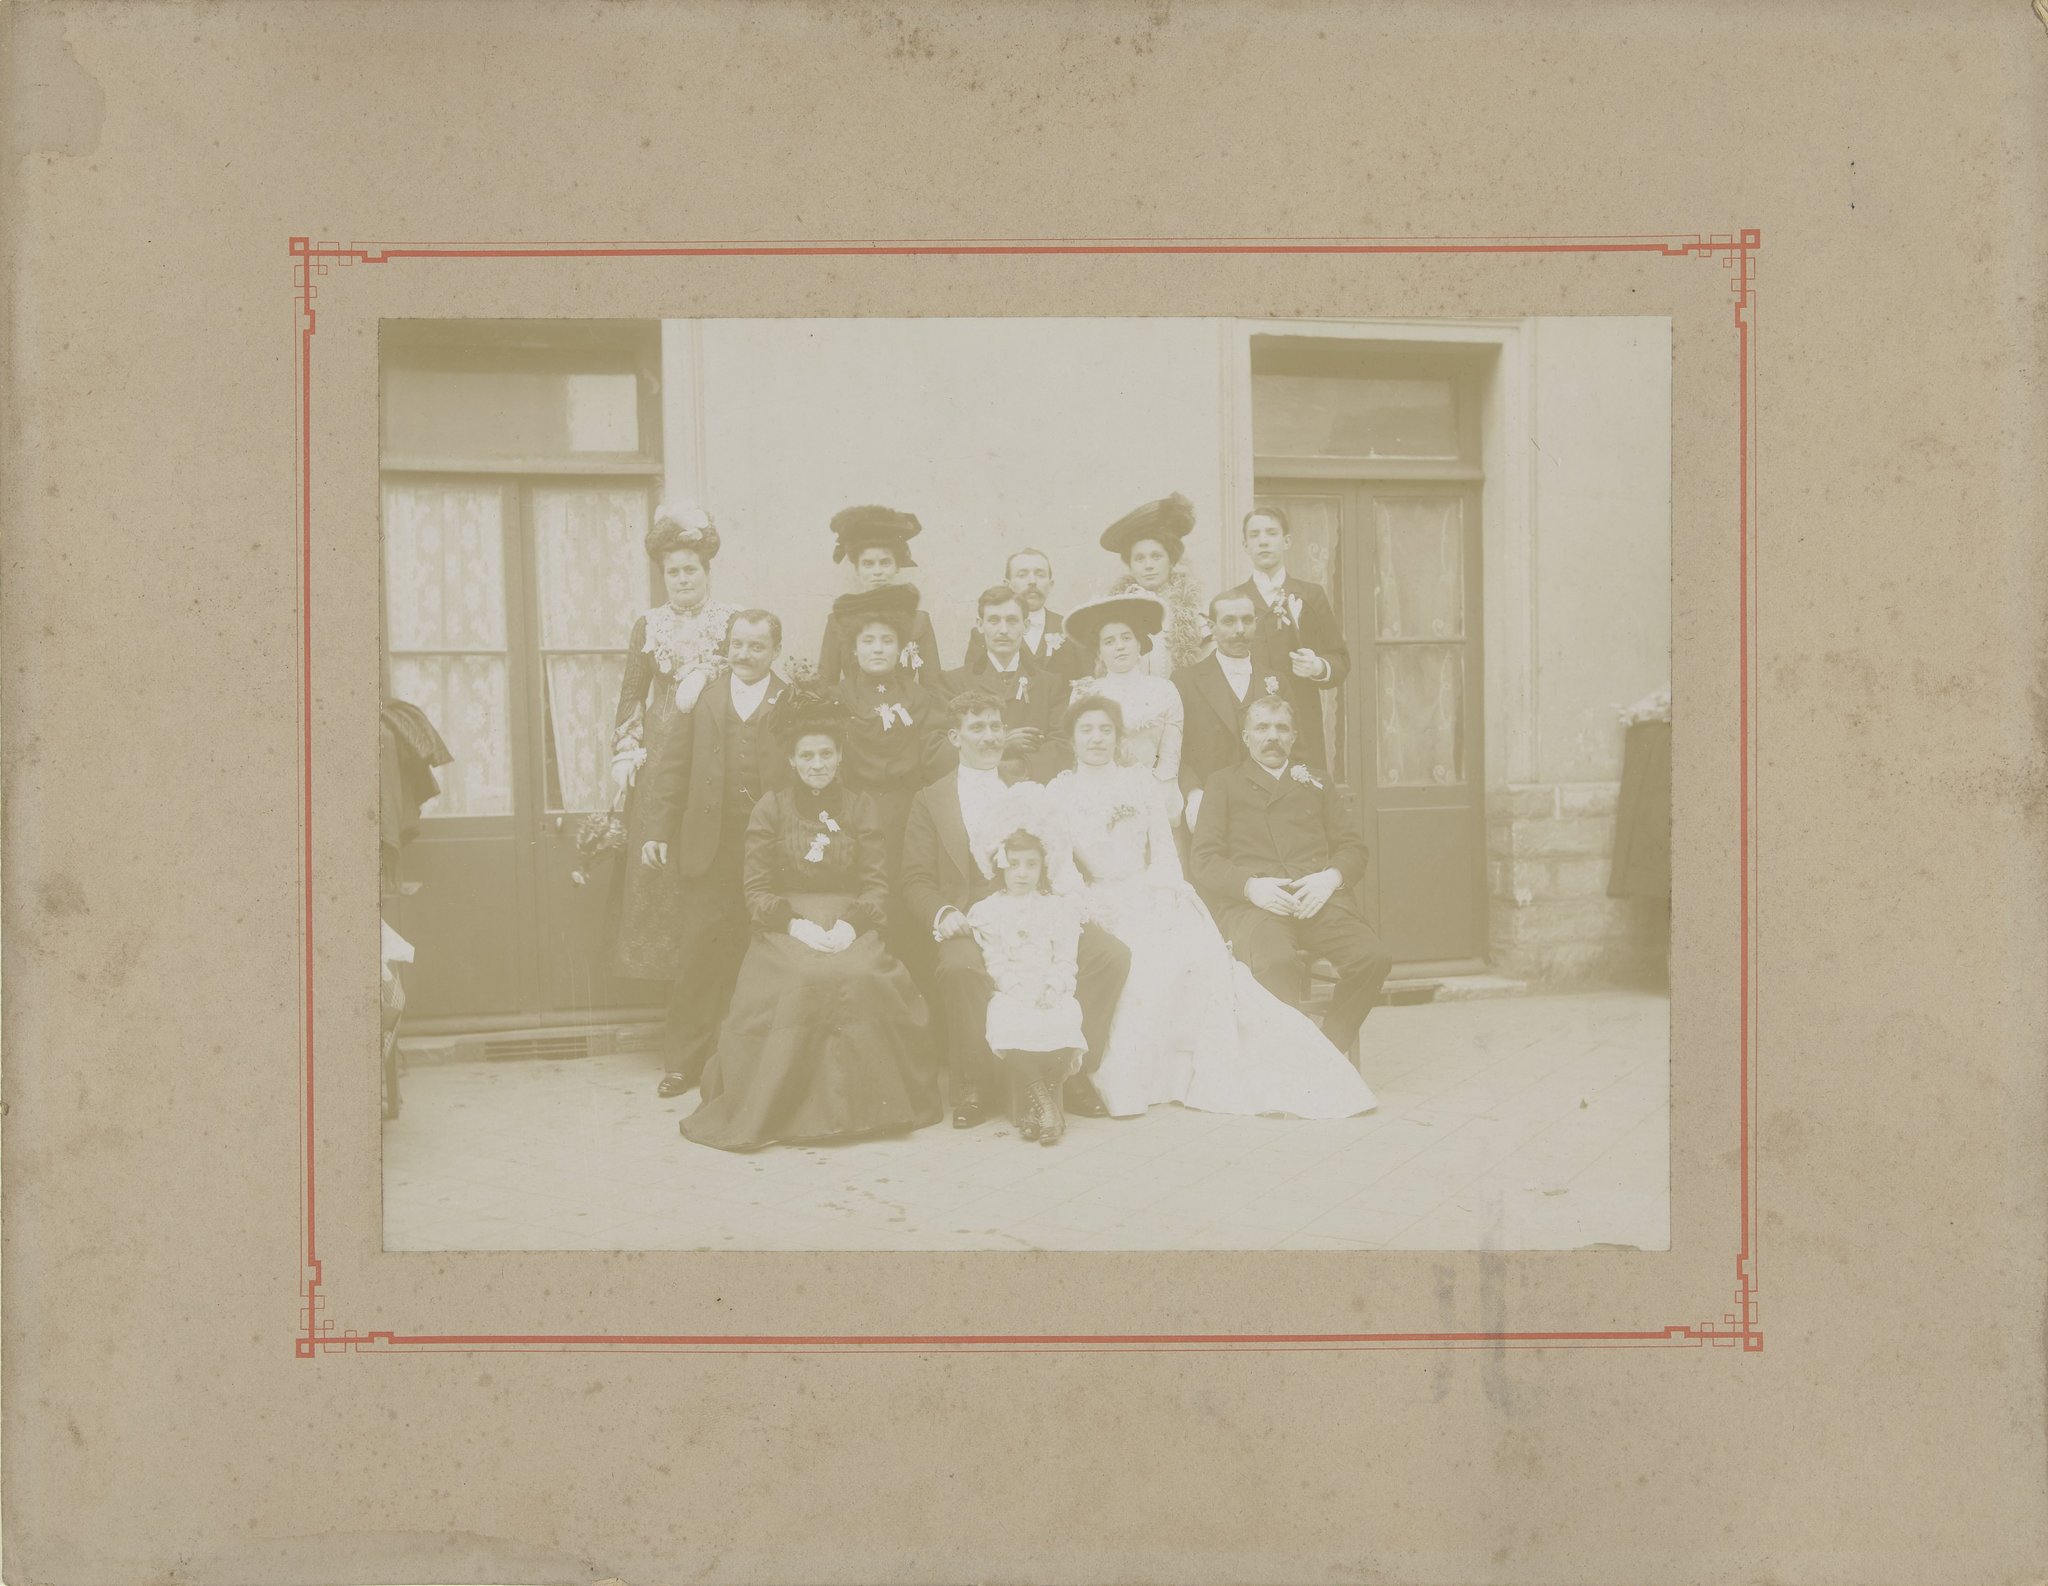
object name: photograph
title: Groepsportret van een onbekend bruidspaar met familie voor een huis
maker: Anonymous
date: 1890-1910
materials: paper, cardboard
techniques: gelatin silver print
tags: members of bridal party, anonymous historical persons portrayed in a group, in a group-portrait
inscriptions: inscription: ‘caitre or [?]’